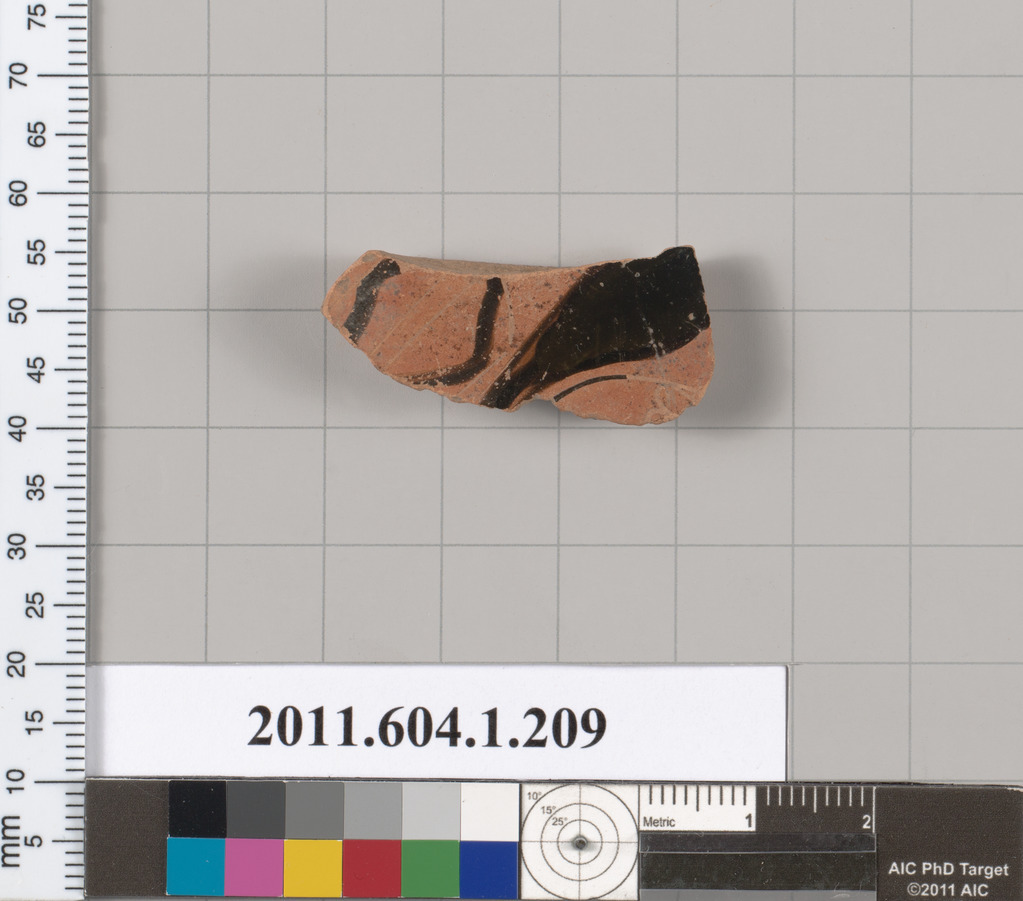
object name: kylix fragment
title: Terracotta fragment of a kylix (drinking cup)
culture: greek, attic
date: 475-451 BCE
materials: terracotta